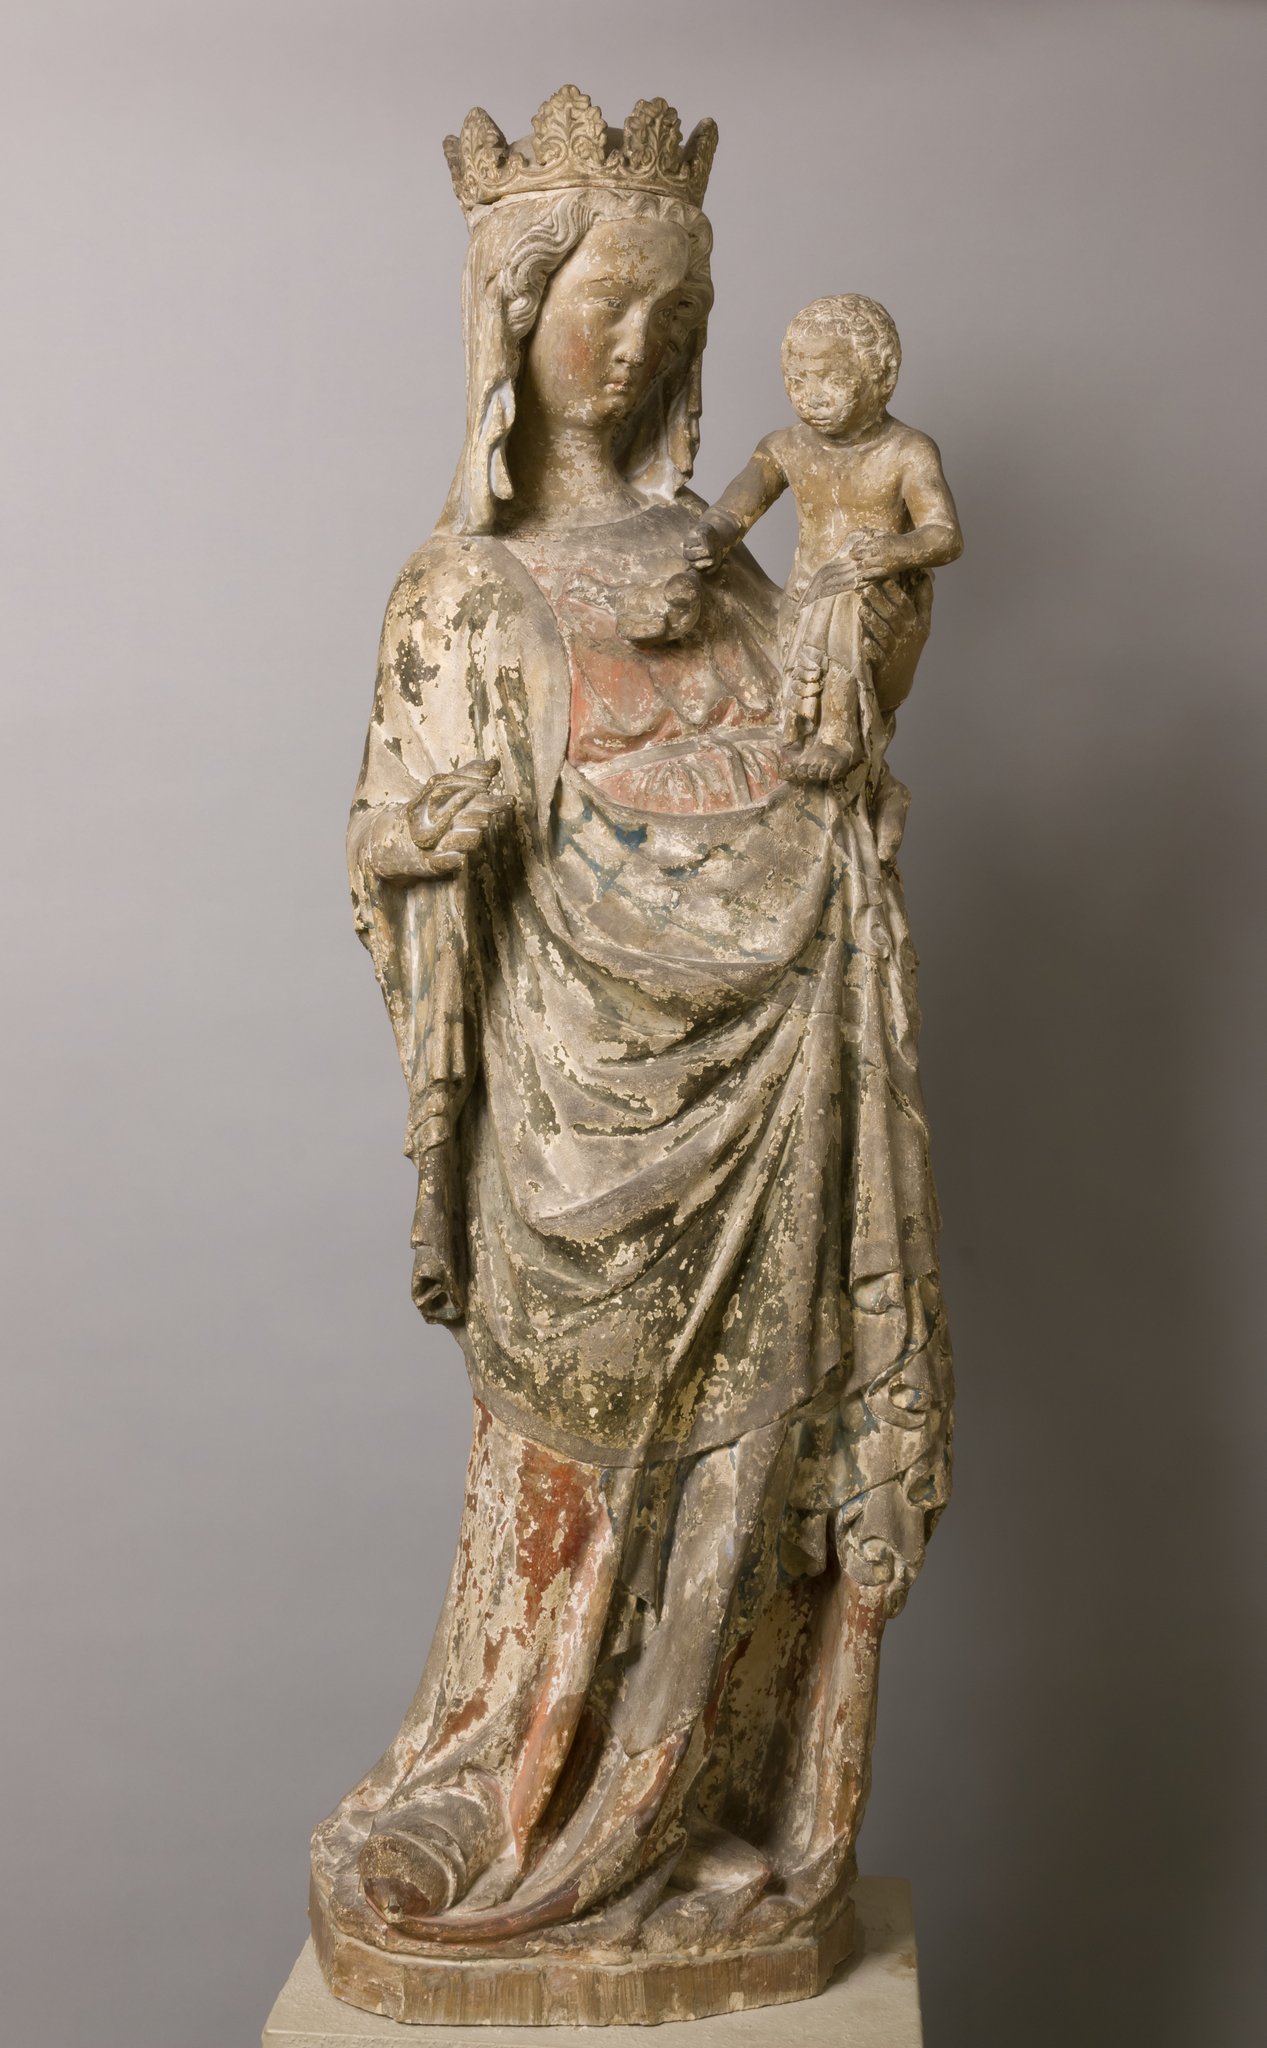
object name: statue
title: Virgin and Child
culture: french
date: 1367-1400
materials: gilt, limestone, paint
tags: madonna and child